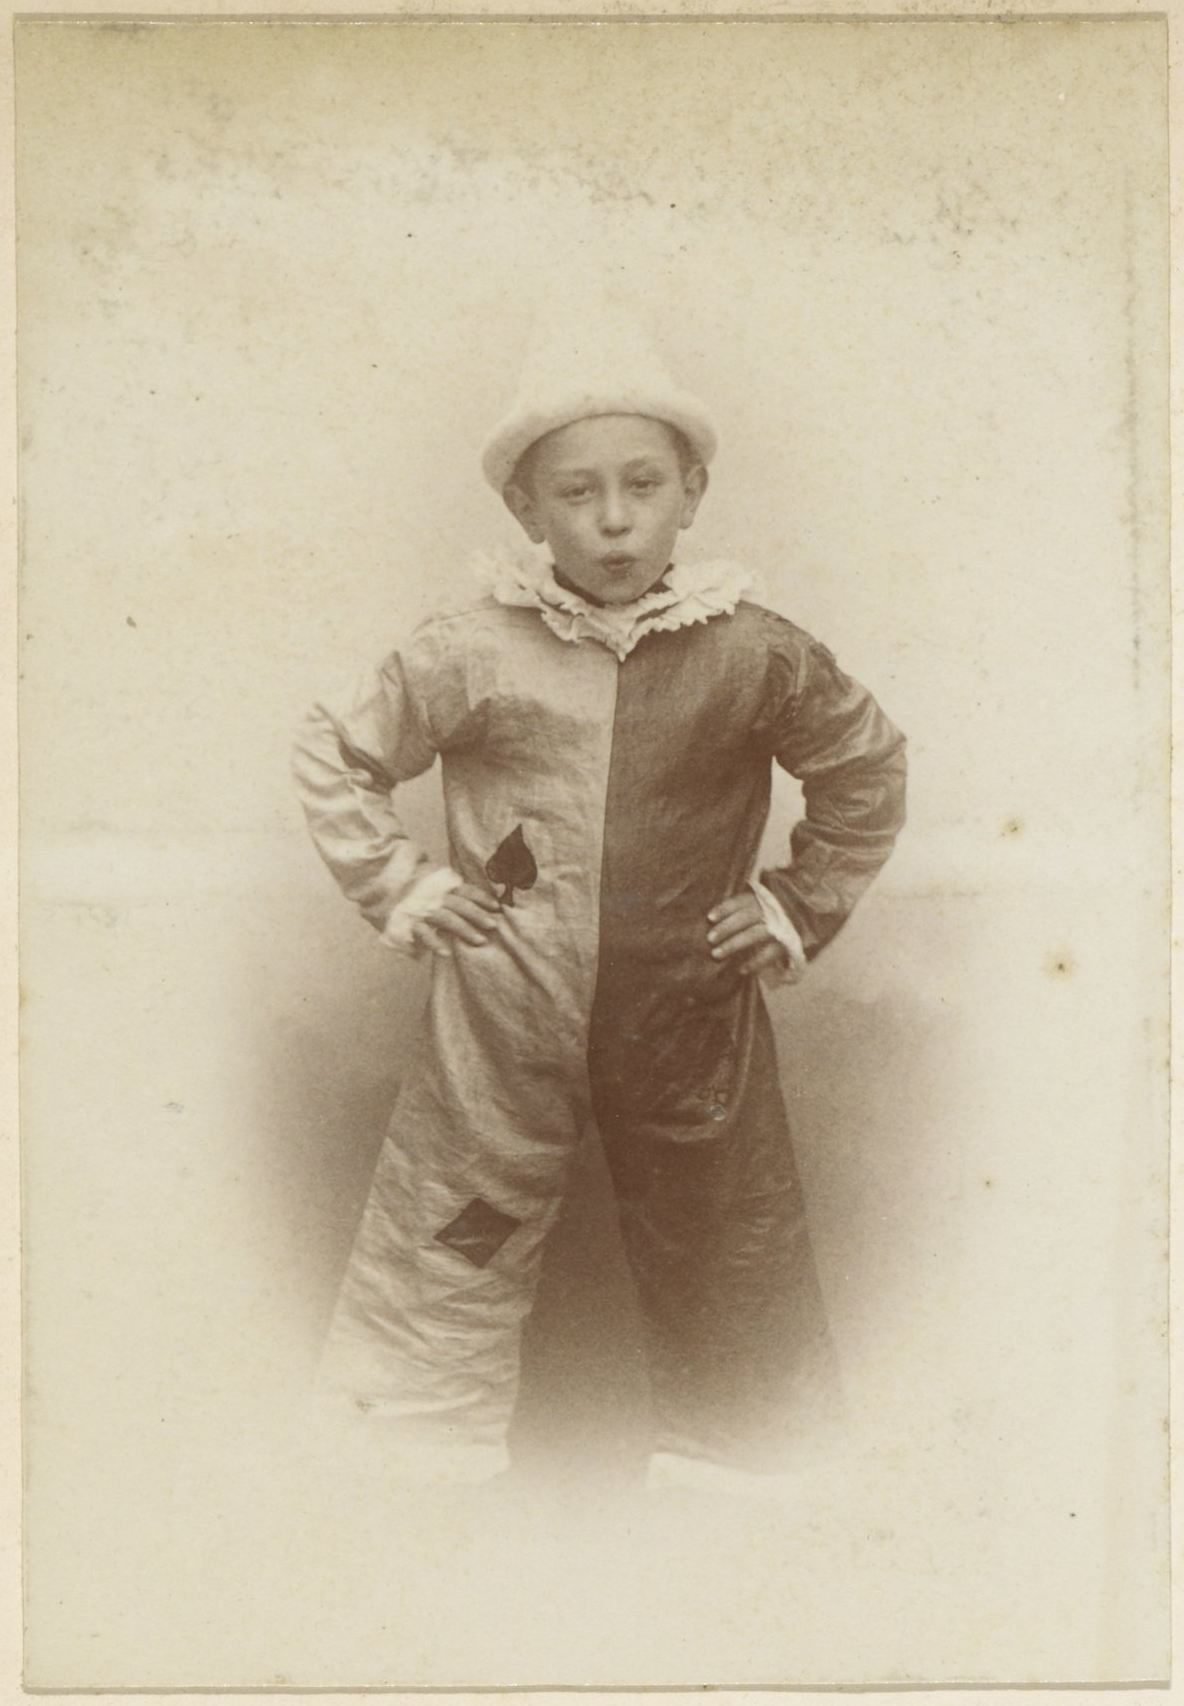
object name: photograph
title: Portret van een Franse jongen, verkleed als pierrot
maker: Anonymous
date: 1900-1910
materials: paper, photographic support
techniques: albumen print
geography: france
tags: types in 'commedia dell'arte': pierrot, child, france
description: Onderdeel van Fotoalbum van een Franse amateurfotograaf met opnames van een familie, distilleerderij Delizy & Doistau Fils, het leger en bezienswaardigheden in Frankrijk.